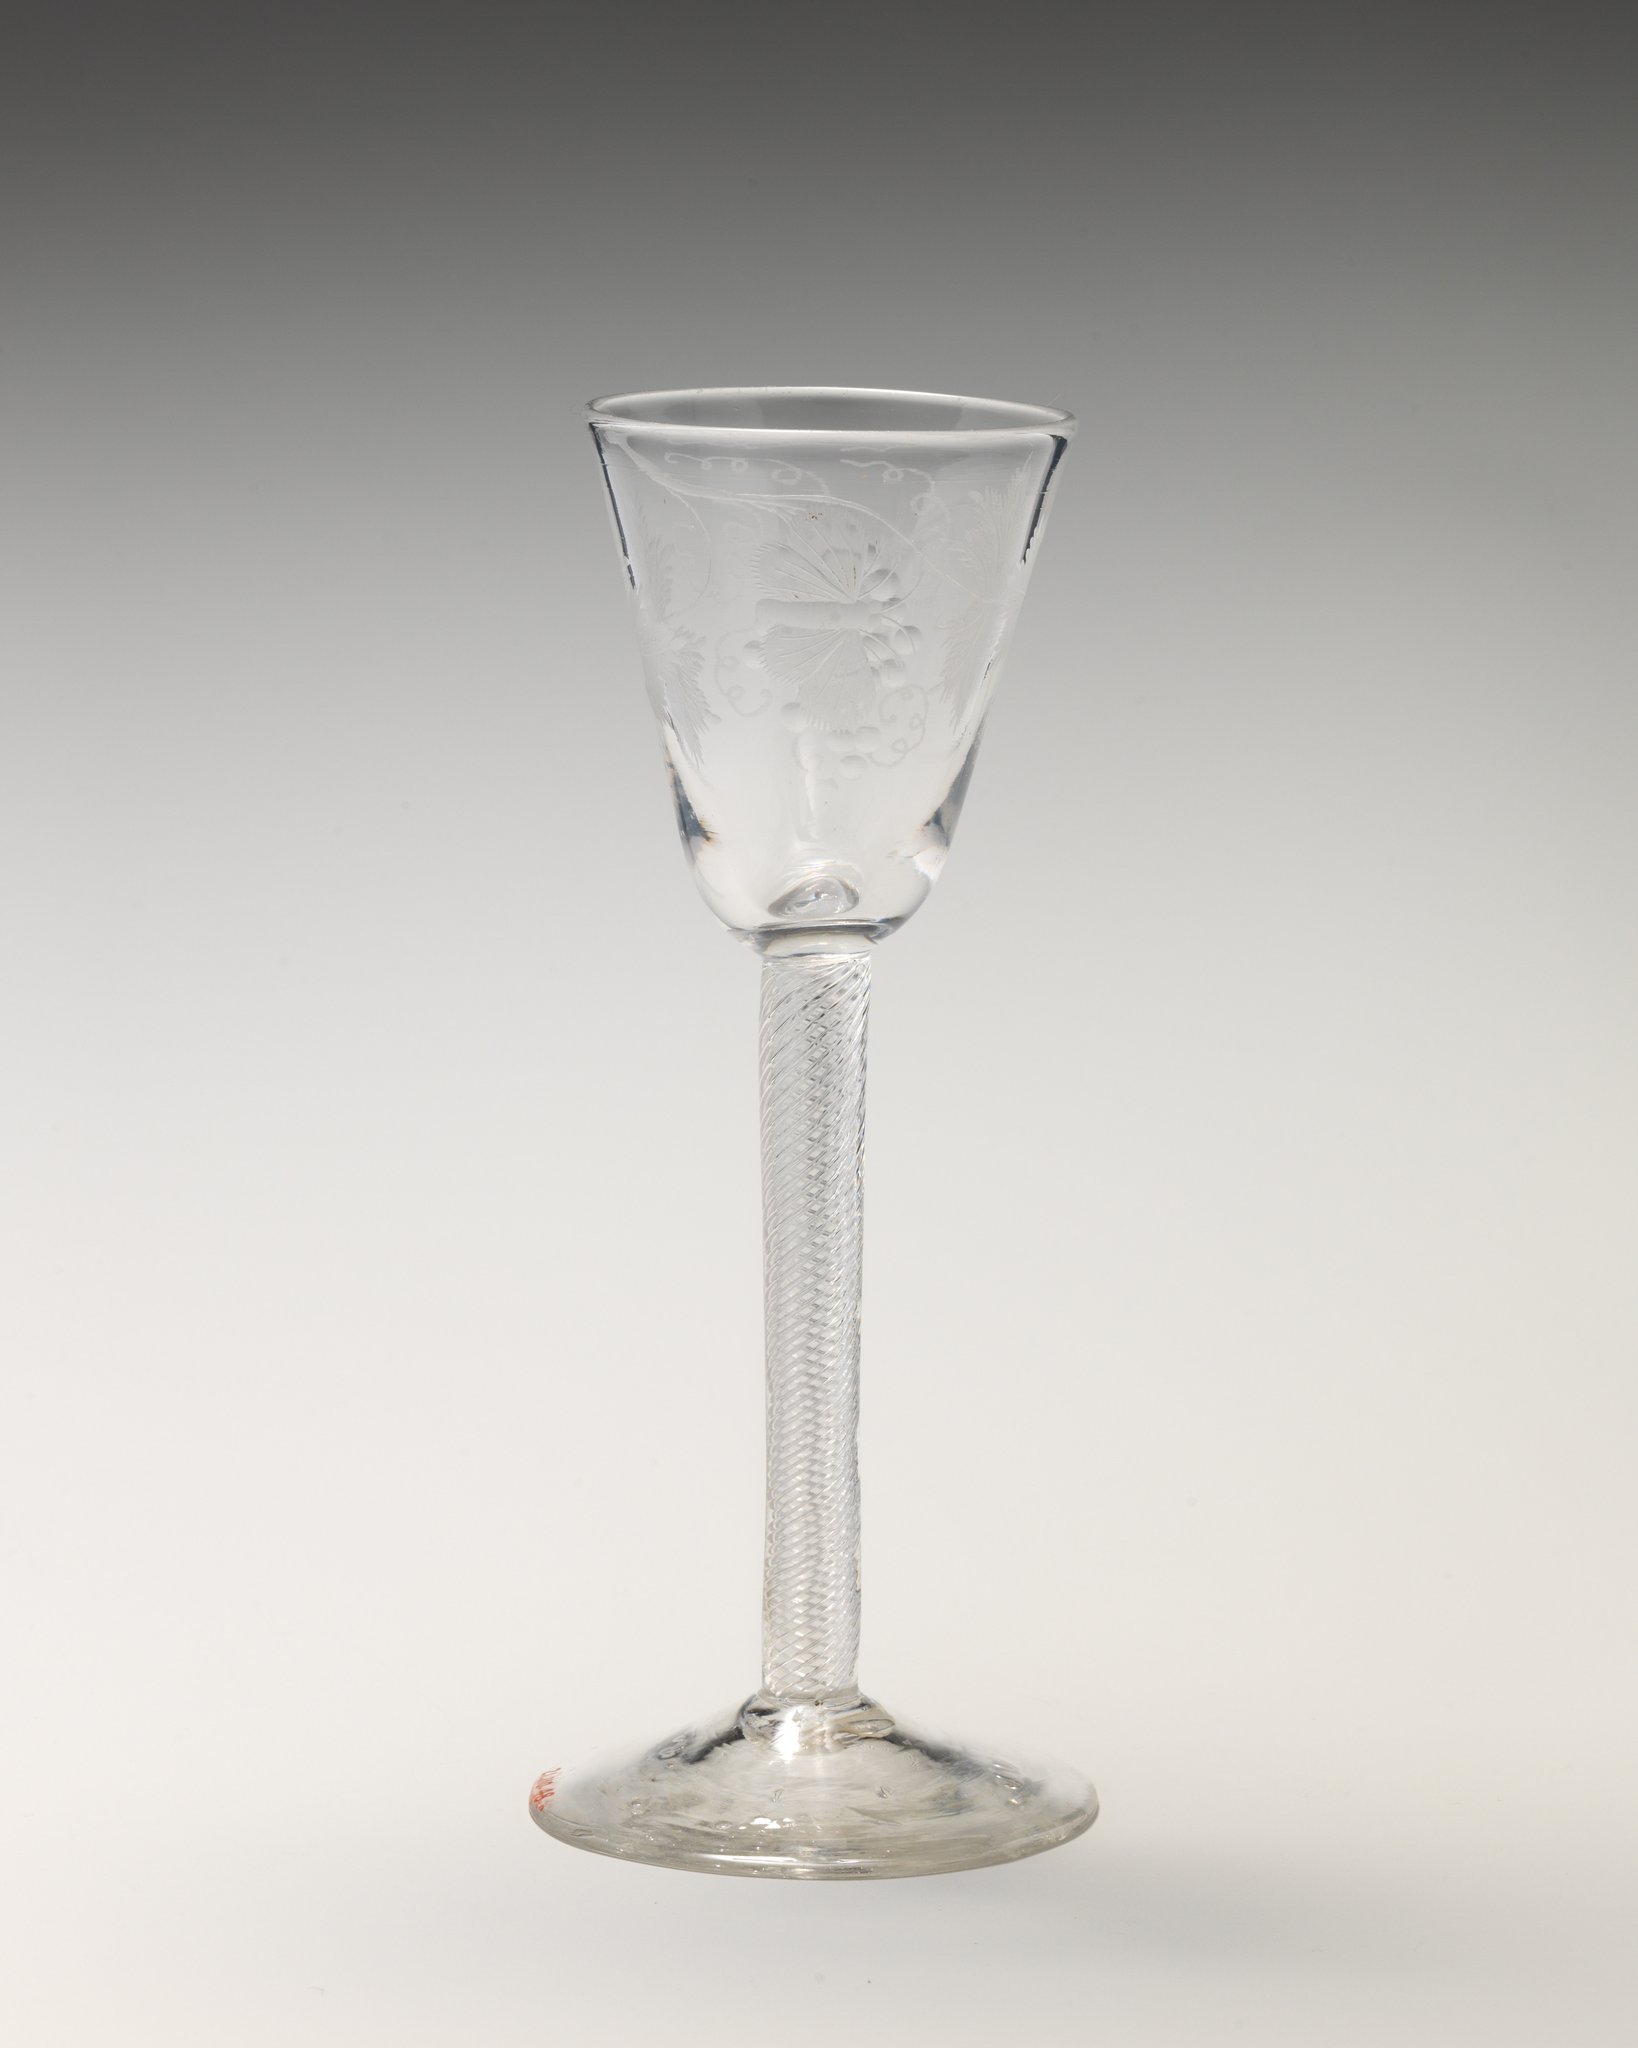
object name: wineglass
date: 1740-1780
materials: glass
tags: grapes